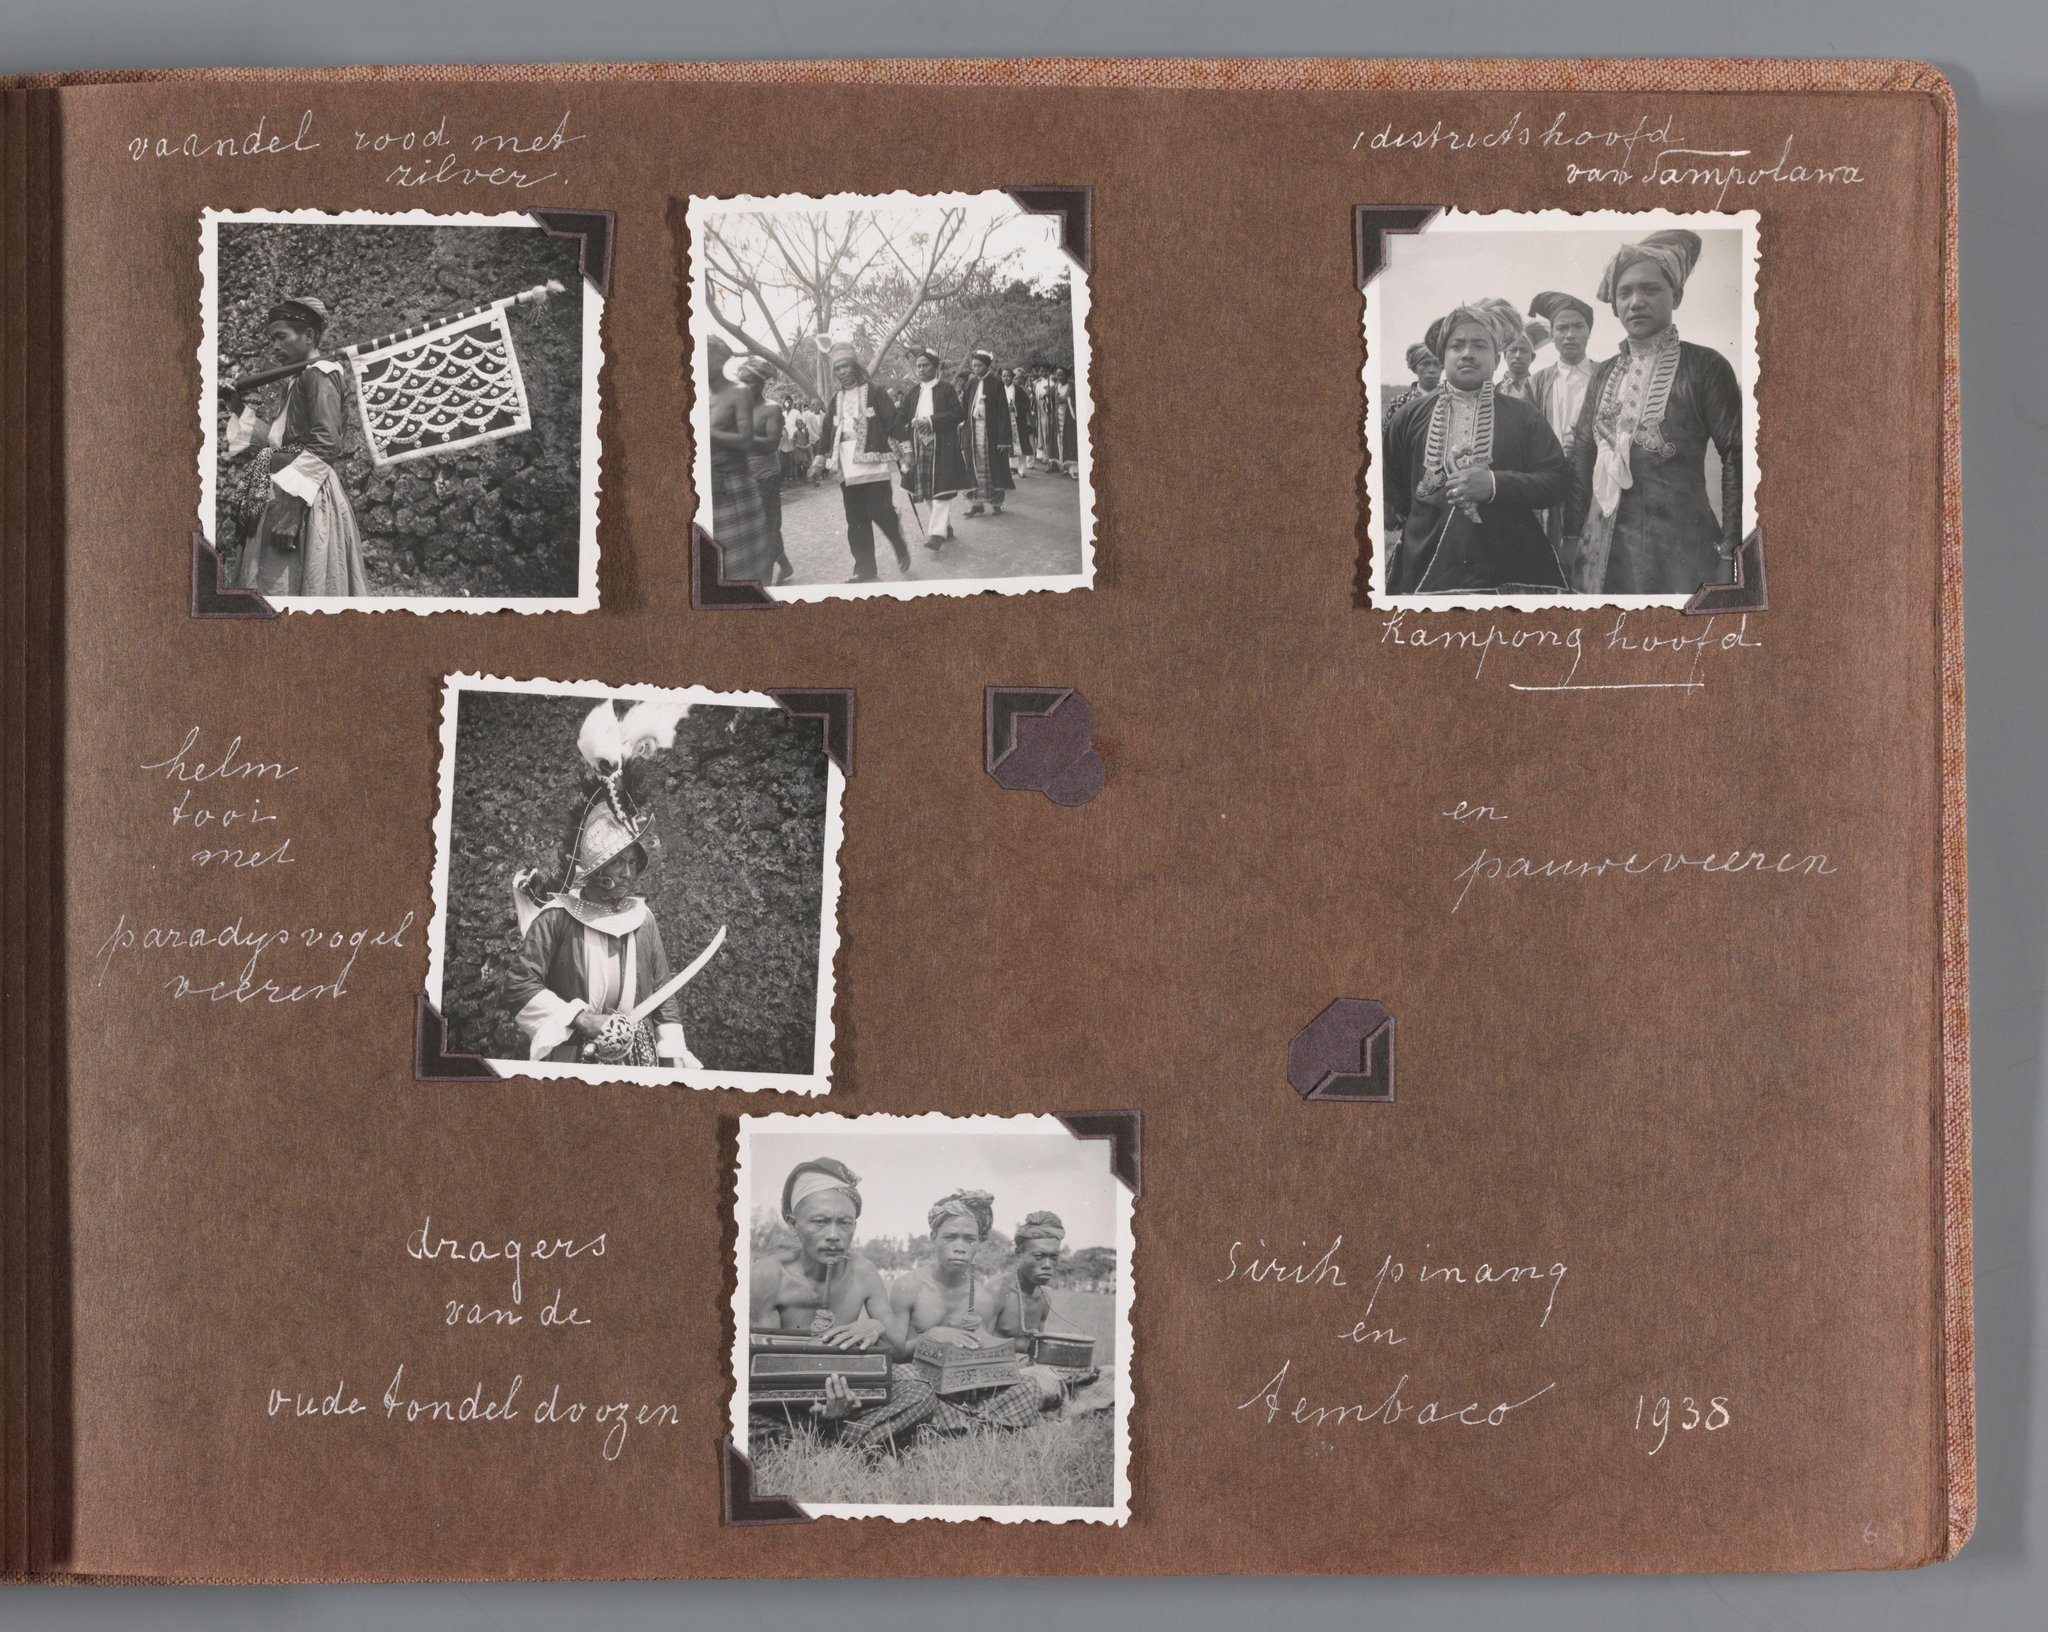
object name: photograph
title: Installatie van de Sultan van Boeton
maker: Anonymous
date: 1938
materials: cardboard, photographic support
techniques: gelatin silver print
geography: celebes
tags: ceremonial celebration of installation of a ruler, folk costume, regional costume, colonial government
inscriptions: inscription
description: Albumblad met vijf foto's van de ceremoniële installatie van de nieuwe sultan van Boeton in 1938. Hoogwaardigheidsbekleders en ceremoniële voorwerpen en dracht. Onderdeel van het fotoalbum van familie Vonk op Zuid-Celebes.